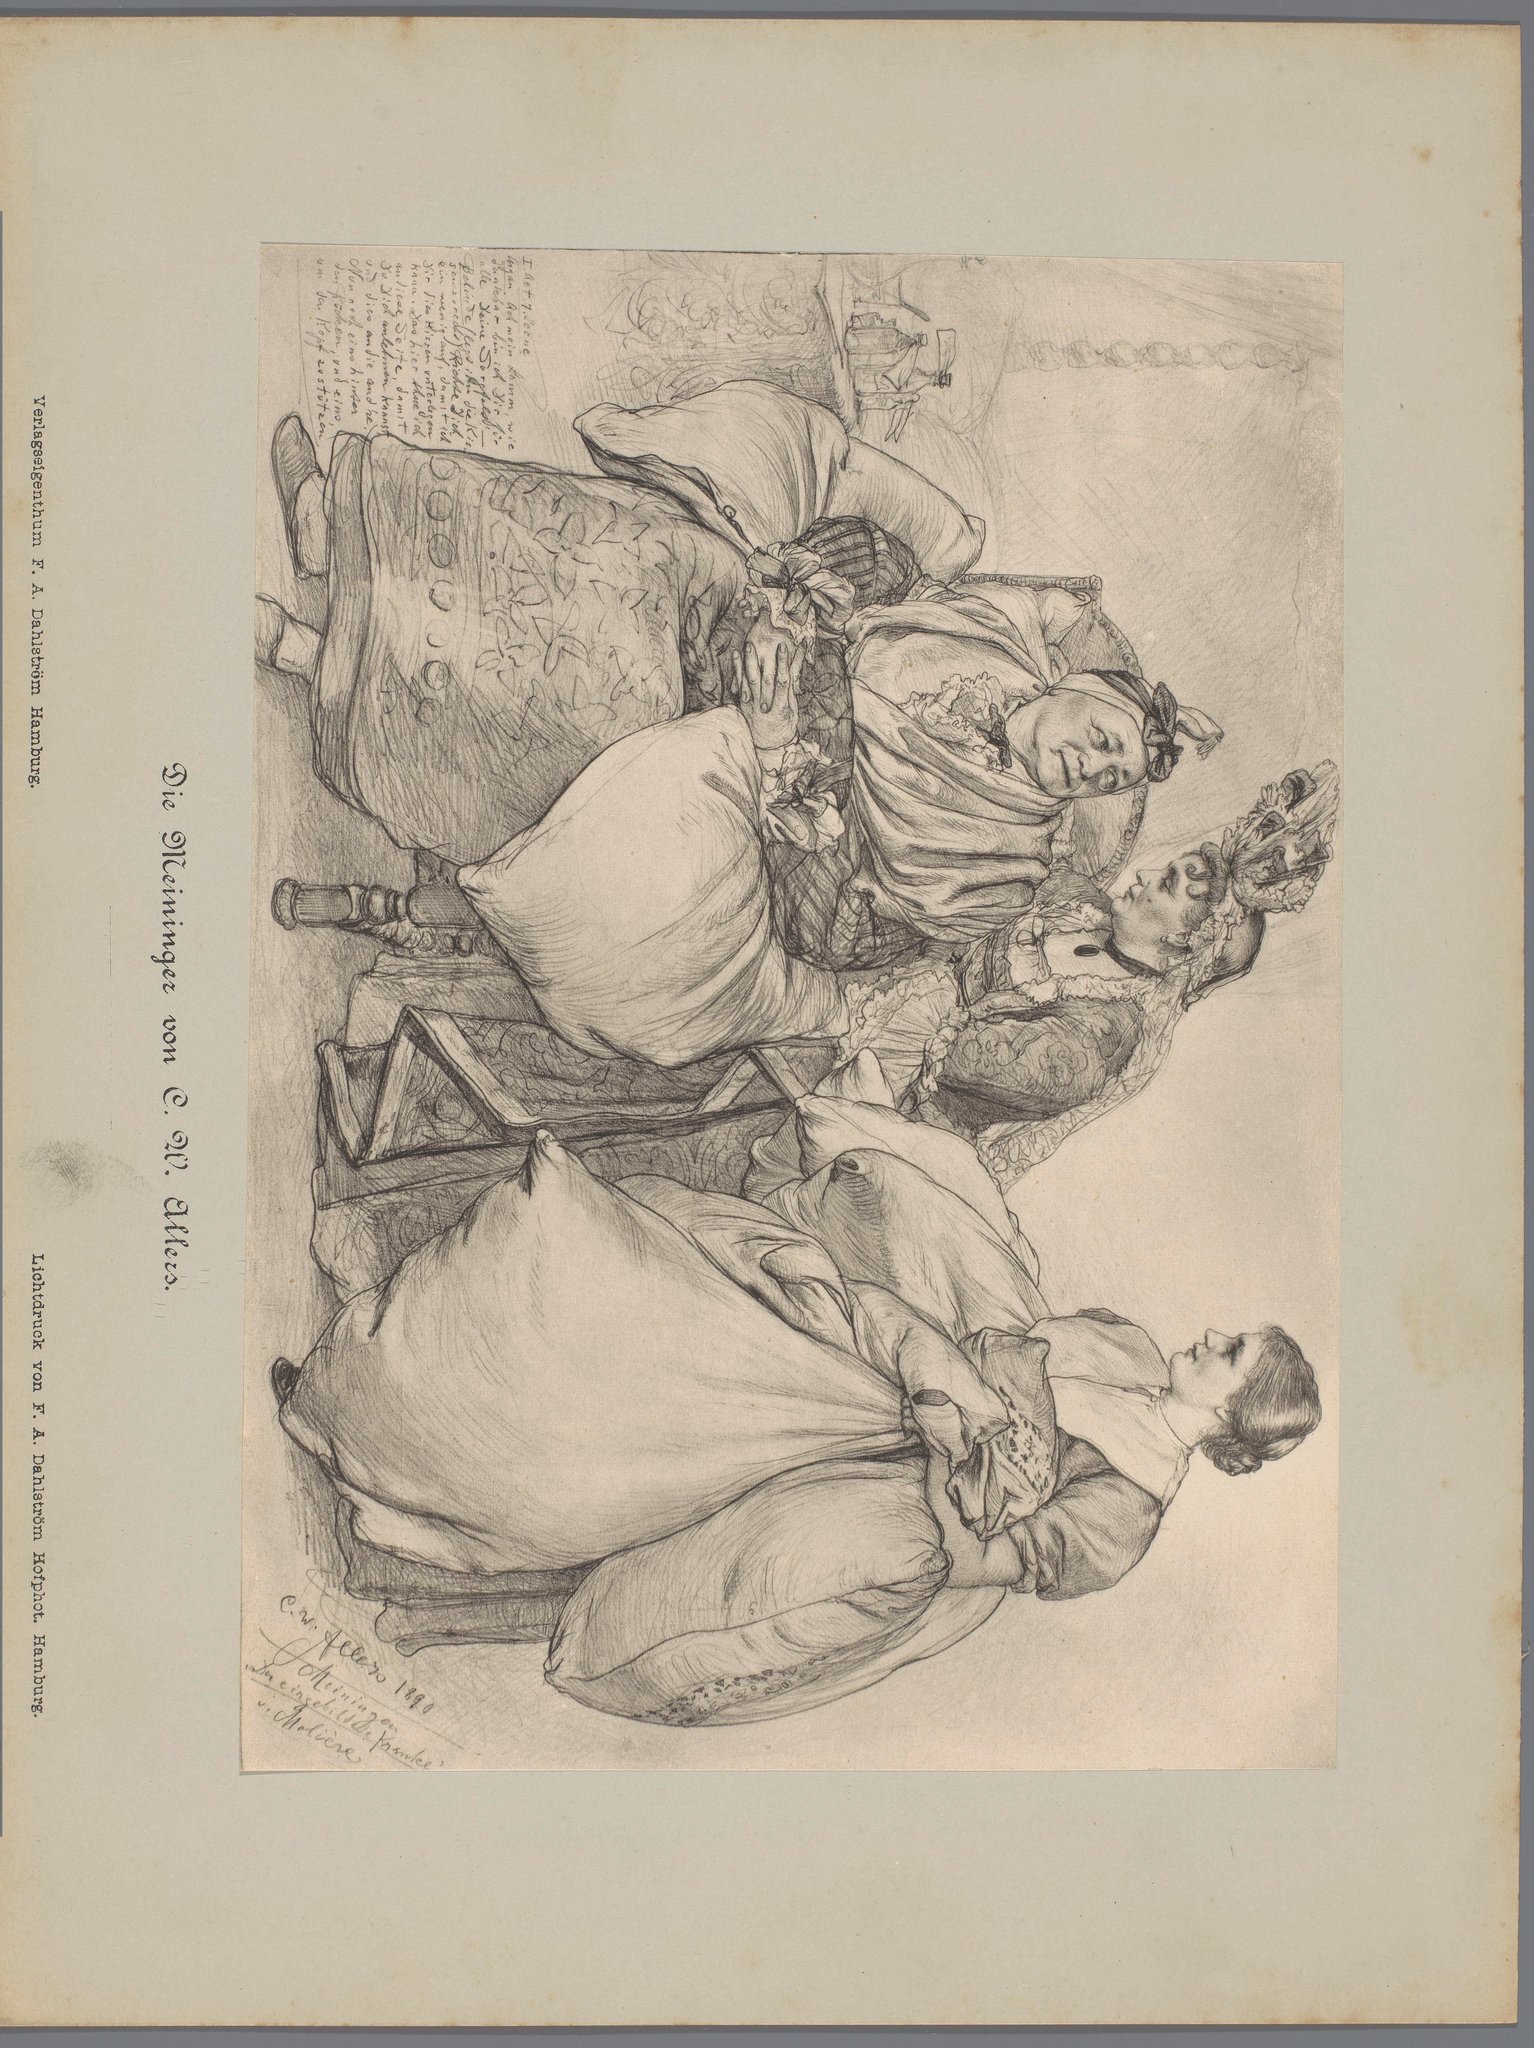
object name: page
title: Die Meininger von C. W. Allers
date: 1890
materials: paper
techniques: photograph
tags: stage costume, rehearsal, studying the role ~ theatre